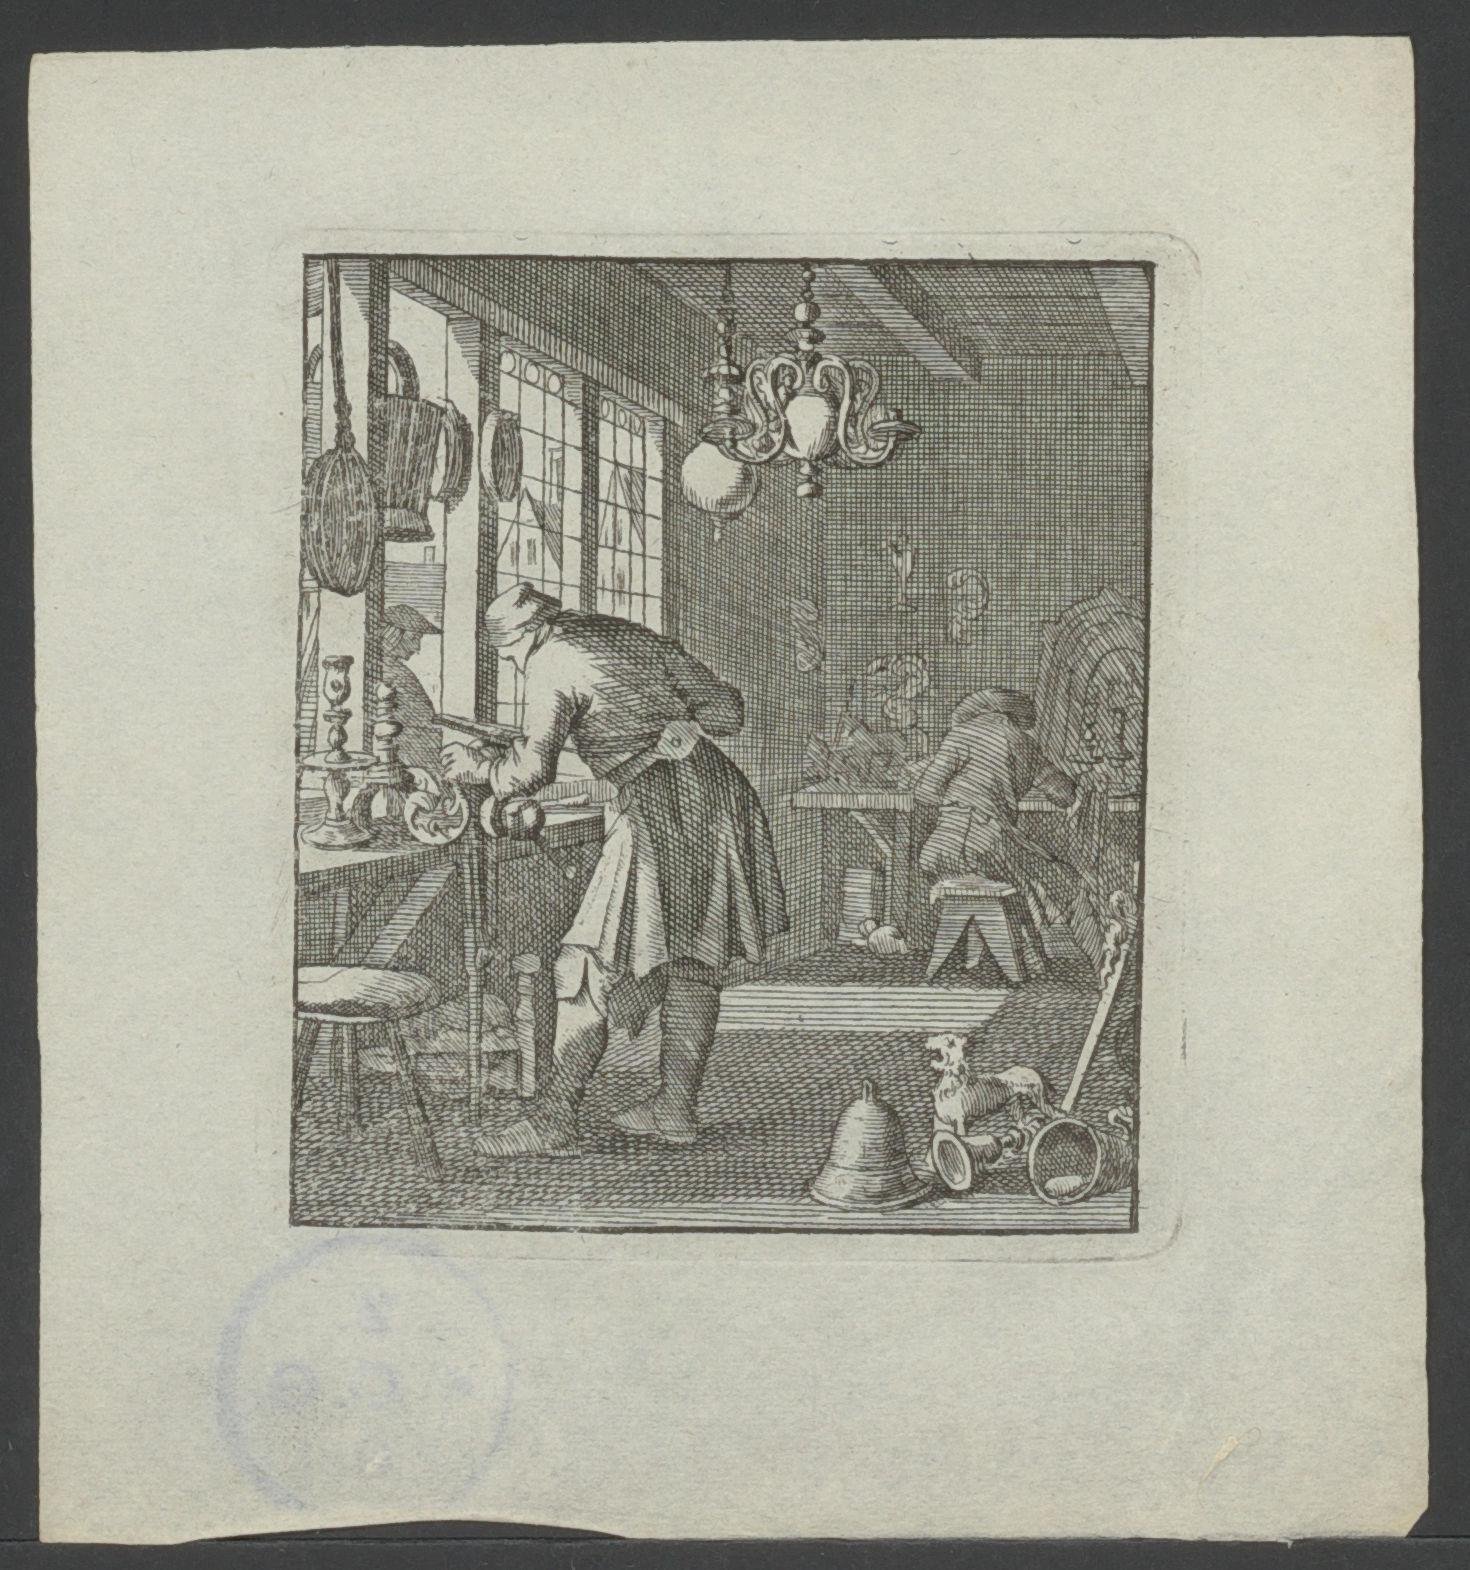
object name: print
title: Geelgieter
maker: Anonymous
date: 1694-1799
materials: paper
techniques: engraving, etching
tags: handicrafts, craftsman at work, handicrafts ~ metal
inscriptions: collector's mark: Lugt 1641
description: Onderwerpsrubrieken binnen de Atlas Zeden en Gewoonten: Handel, Nijverheid en Verkeer, Beroep en bedrijf, Complete suites.